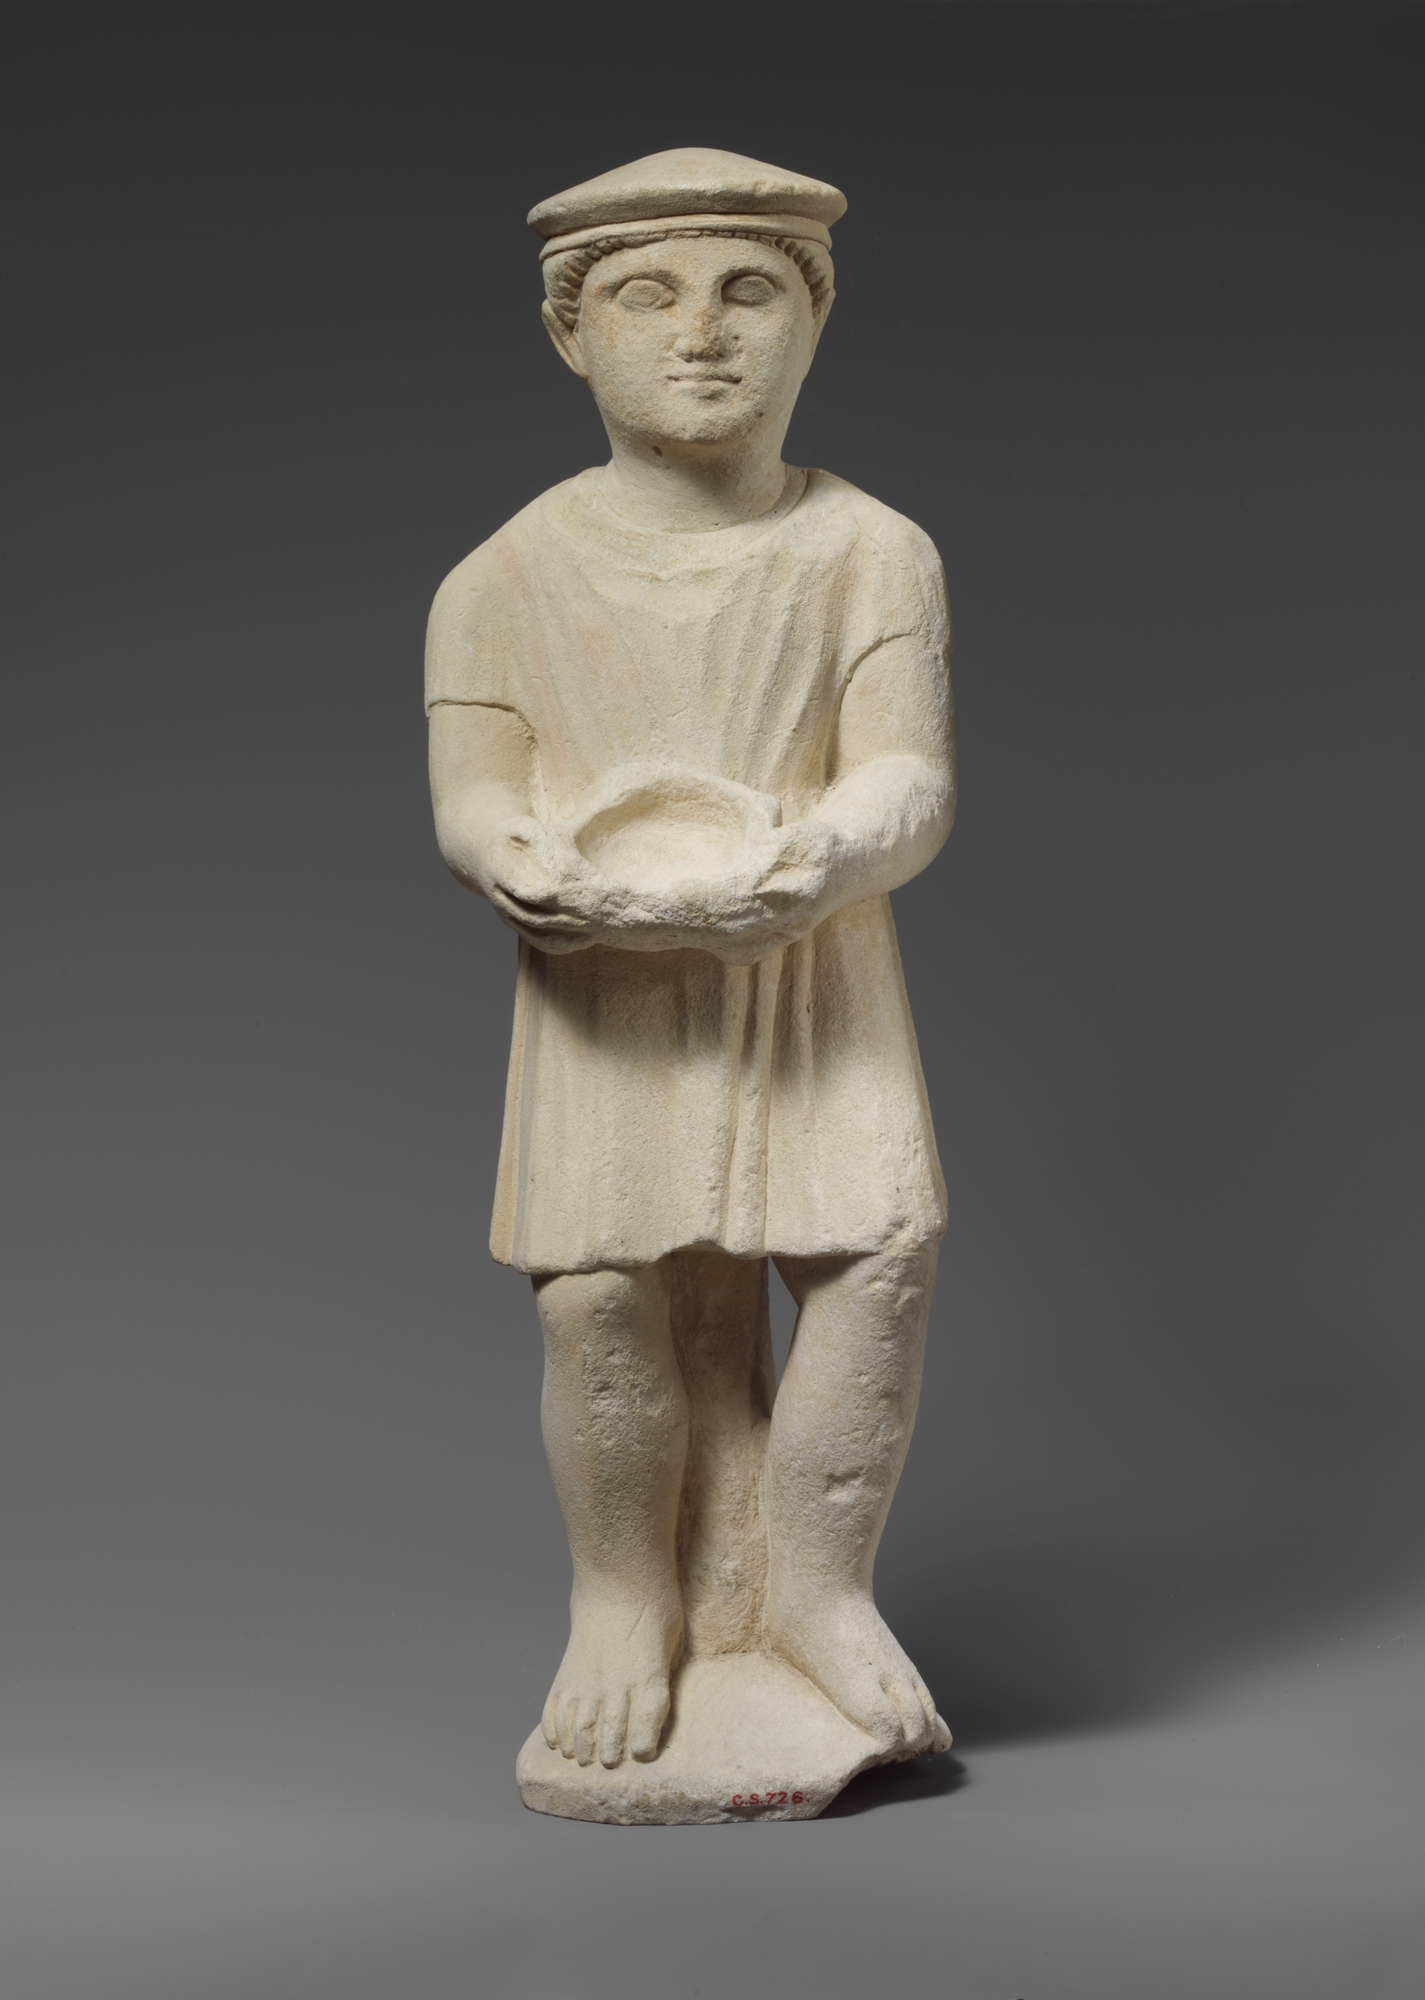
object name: statue of a votary, young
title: Limestone statuette of a boy with a kausia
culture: cypriot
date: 334-1 BCE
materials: limestone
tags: boys